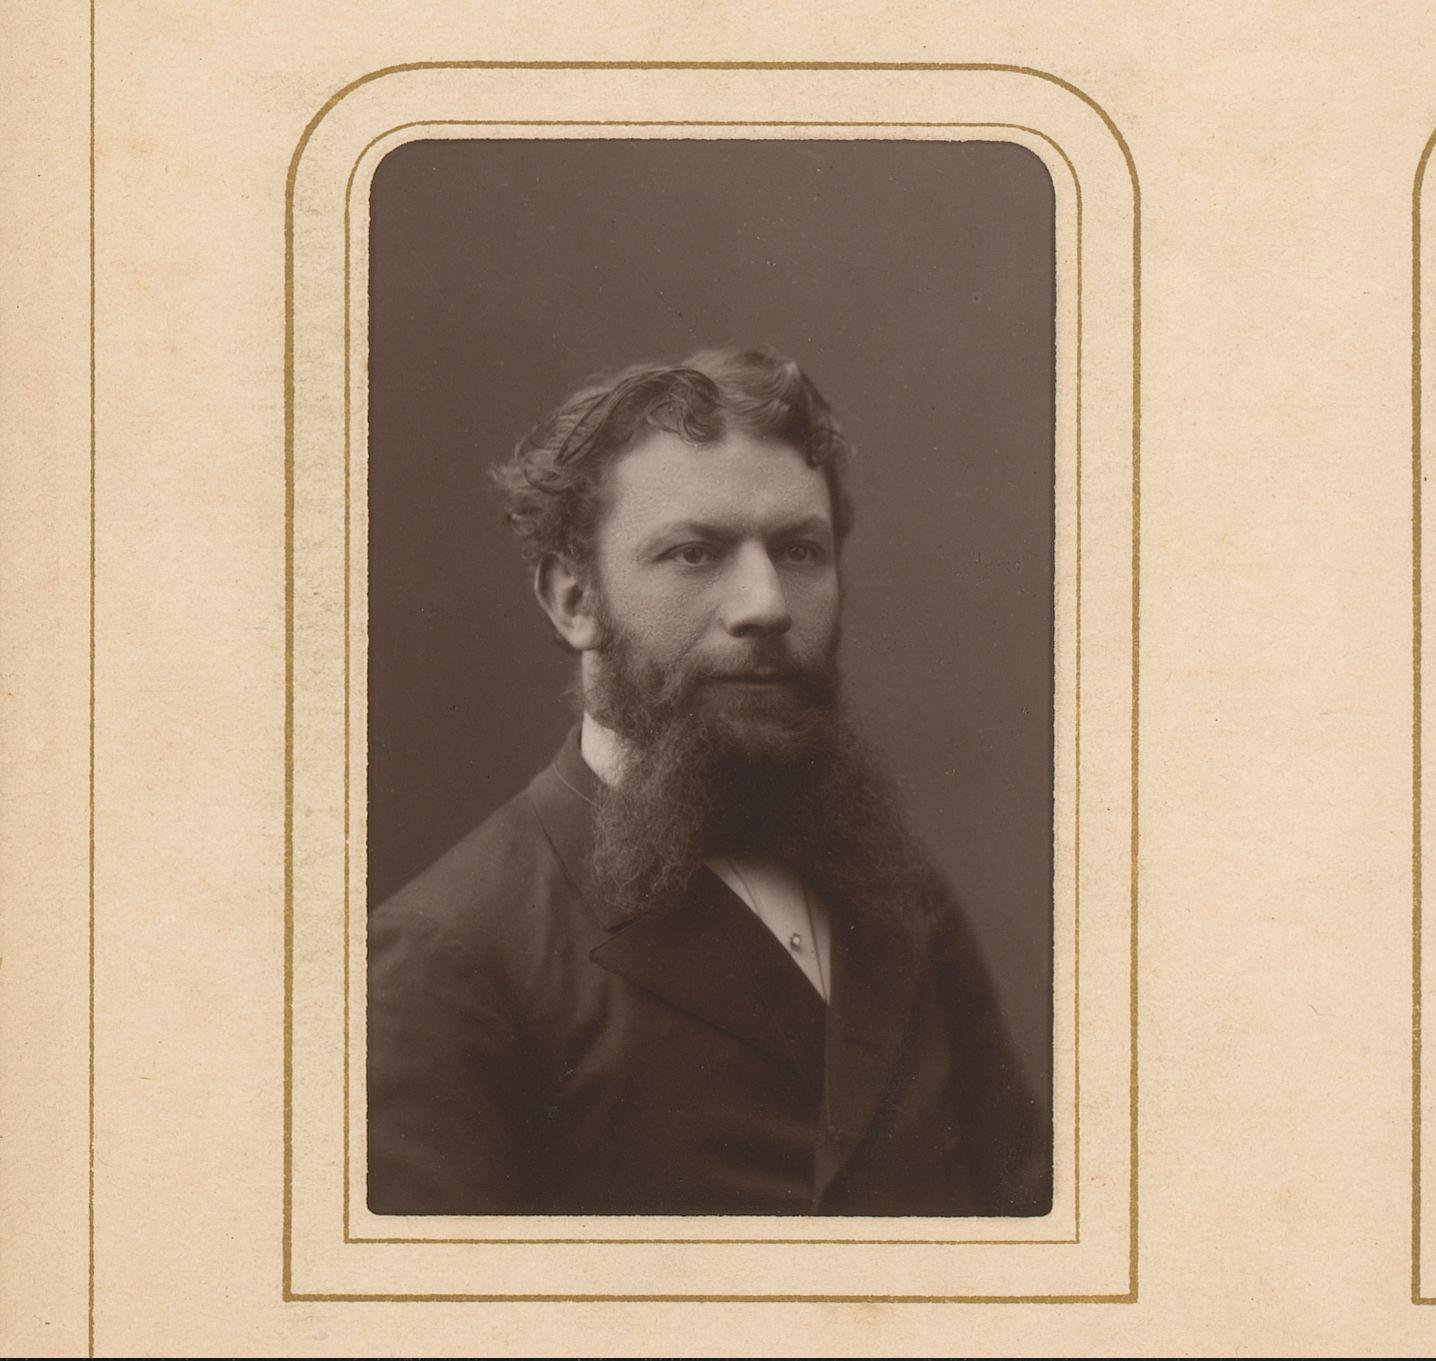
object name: carte de visite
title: Portret van een man met snor en baard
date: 1878-1890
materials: cardboard, paper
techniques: carbon print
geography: brussels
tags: moustache, historical persons, beard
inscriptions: inscription: ‘PROCÉDÉ INALTÉRABLE/ Photographie au Charbon/ (...)/ Géruzet Frères/ Photographes de S.M. la Reine des Belges/ 27B, Rue de l'Ecuyer/ Bruxelles/ Les Clichés sont conservés.’